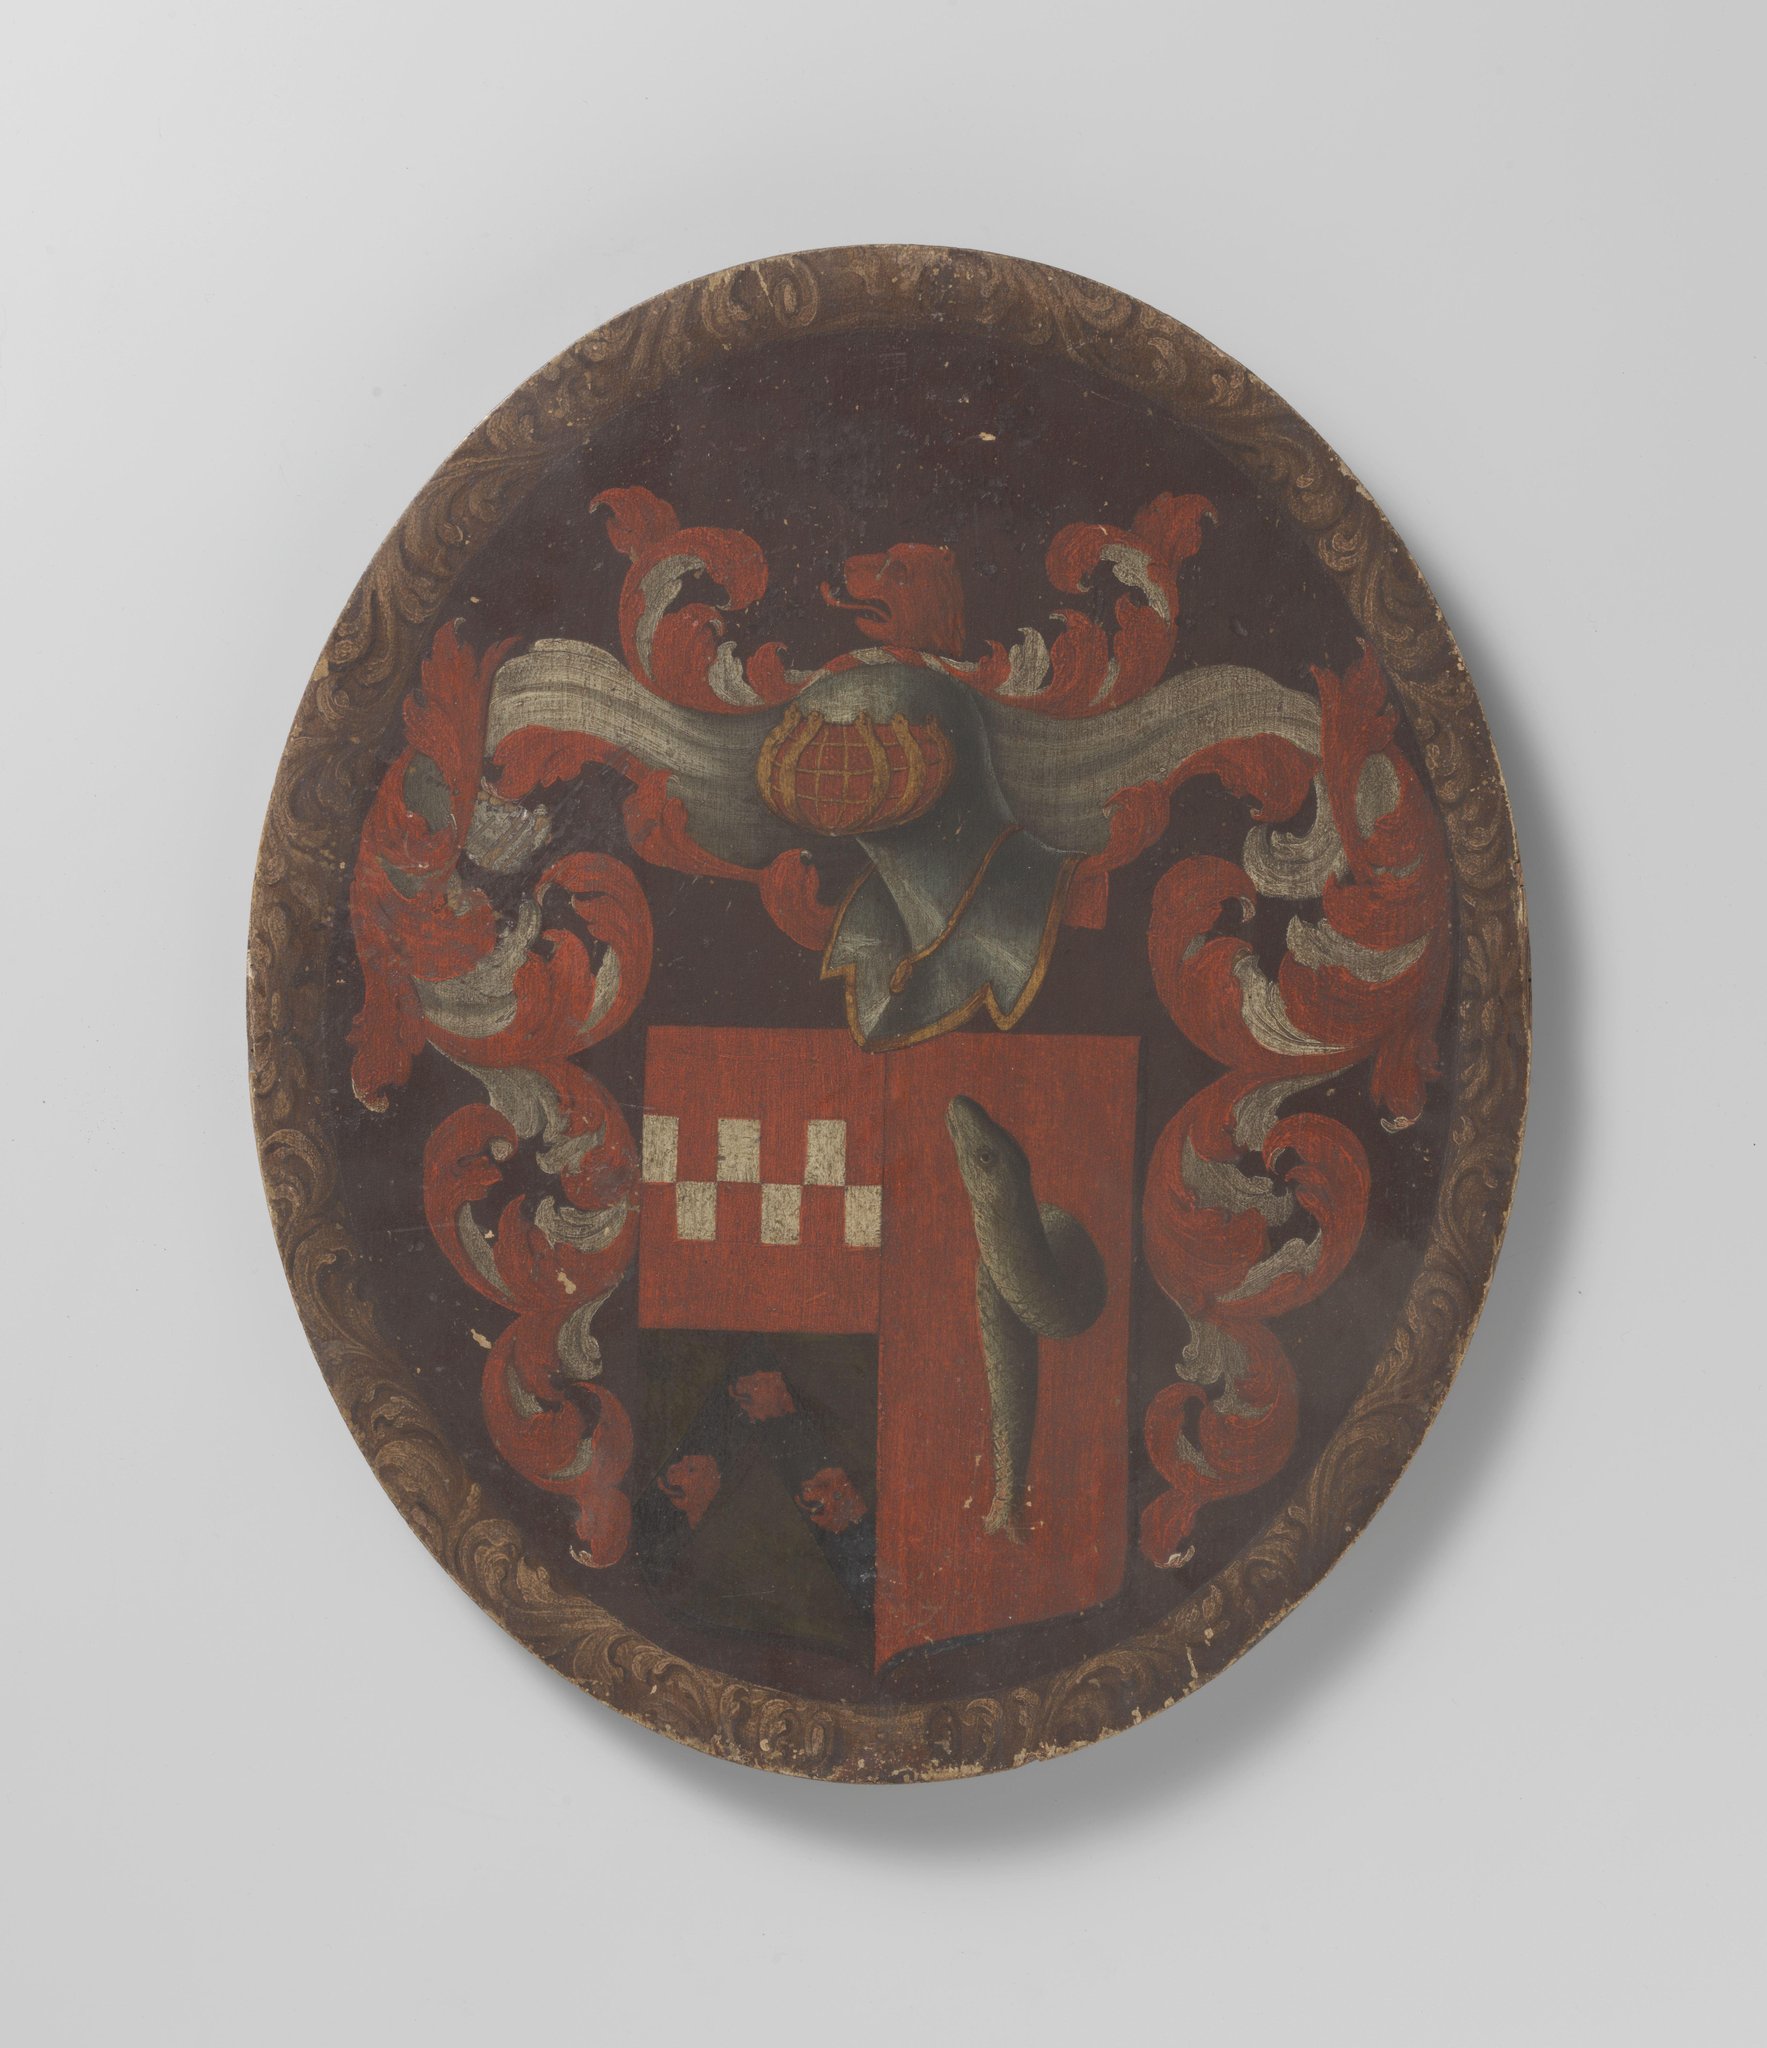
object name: wapenbord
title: Wapenbord met vis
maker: Anonymous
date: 1881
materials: panel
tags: armorial bearing, heraldry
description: Ovaal houten wapenbord. Het wapen is in drieën verdeeld: links twee kwartieren waarvan het bovenste vertoont witte kantelen op rood, het onderste een zwarte keper met drie rode leeuwekoppen. De rechter helft van het wapen draagt een natuurlijk gekleurde vis op rode grond.